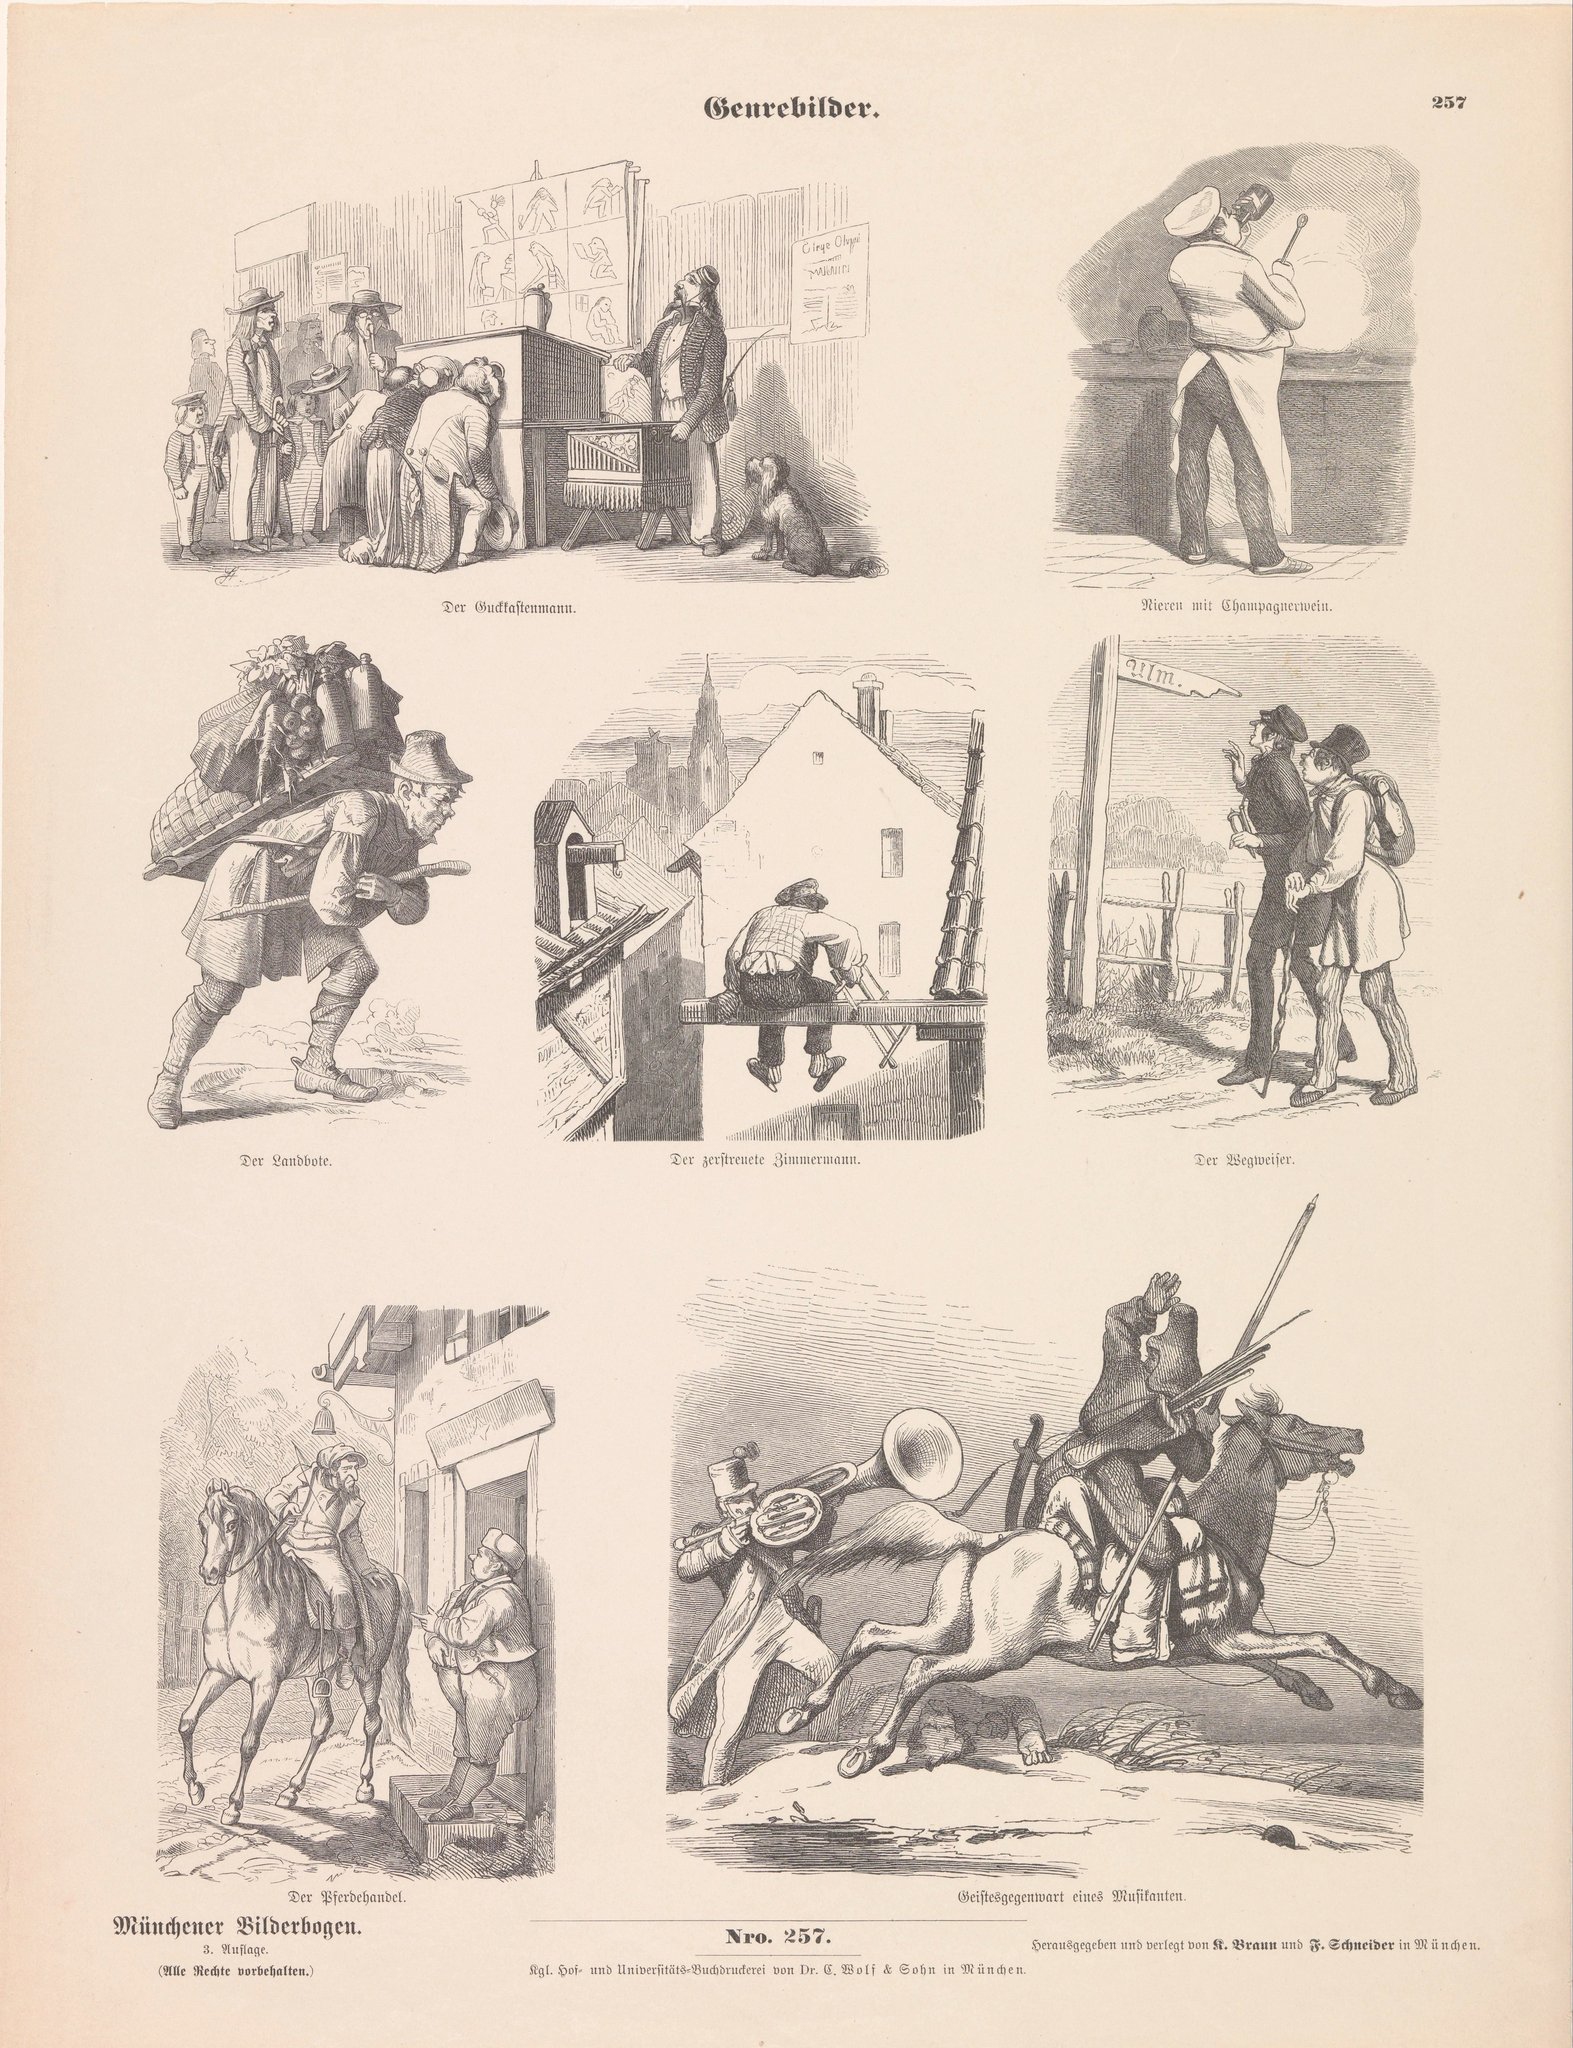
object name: popular print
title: Munchener Platen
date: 1848-1898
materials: paper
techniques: engraving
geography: munich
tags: street-organ, 'pierement', peep-show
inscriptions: collector's mark: Lugt 2228, collector's mark: Lugt 4780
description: Blad met zeven genretaferelen, waaronder een man met een kijkkast en een draaiorgel. Onder elke afbeelding een onderschrift in het Duits. Rechtsboven genummerd: 257. Onder genummerd: Nro. 257.